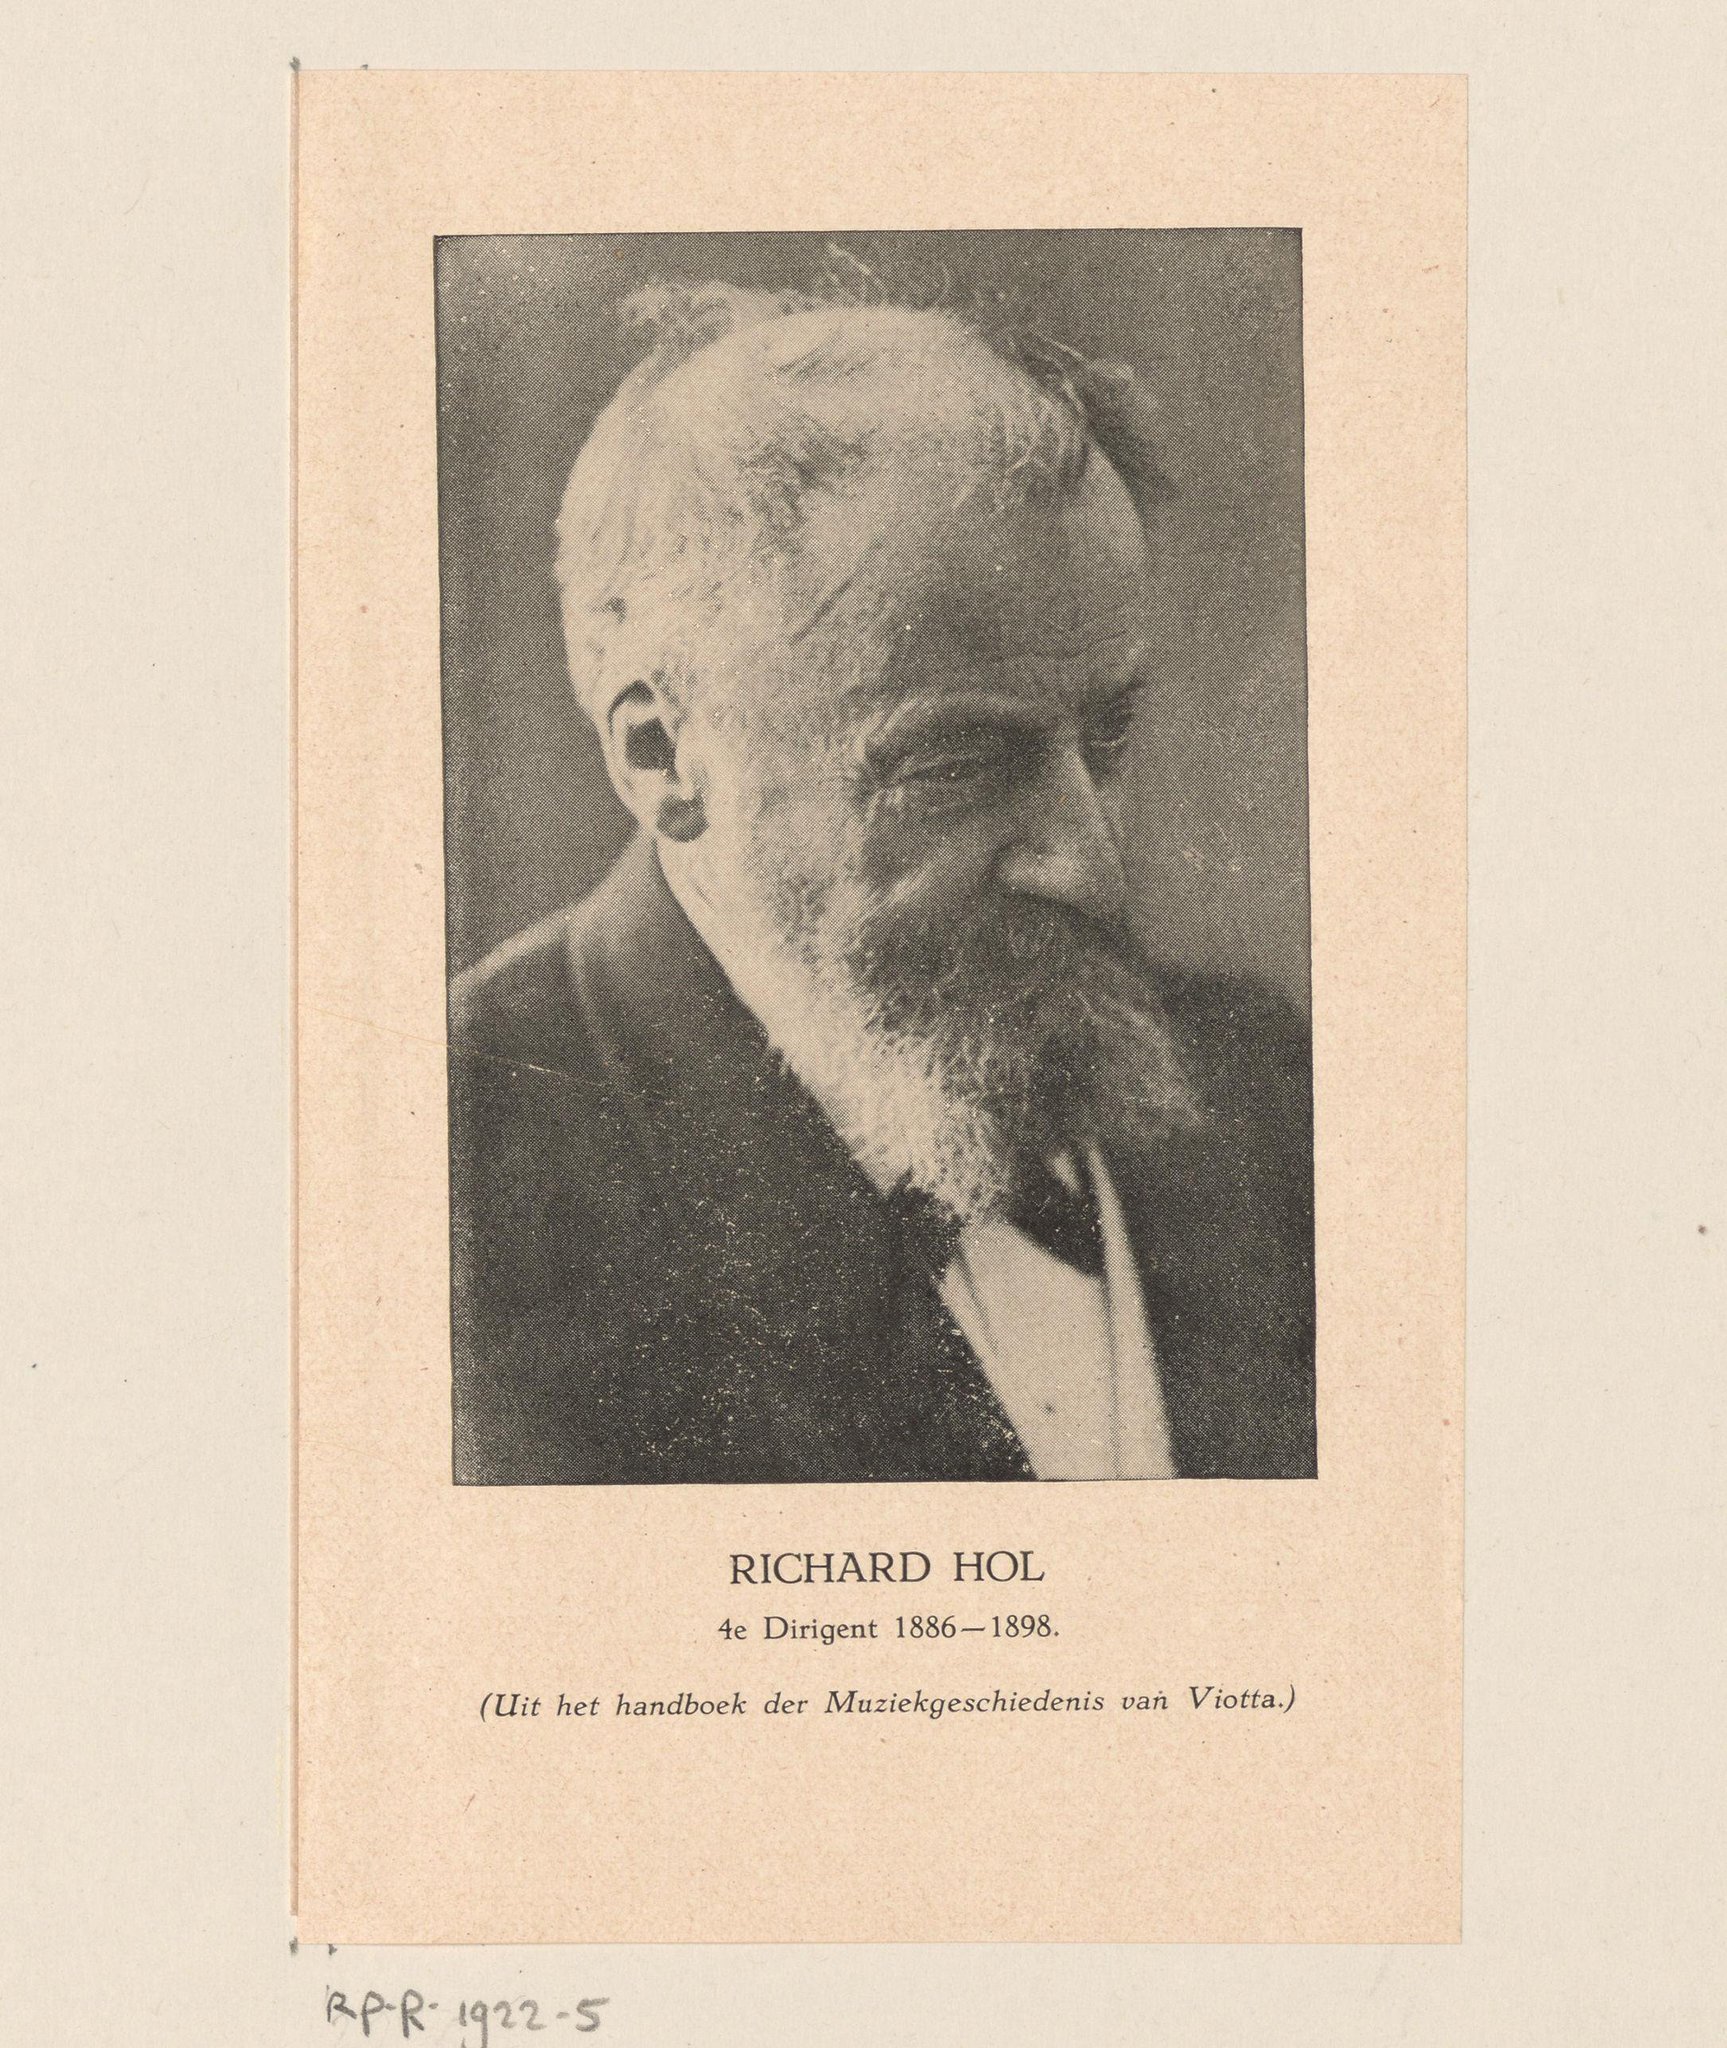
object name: reproduction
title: Portret van Richard Hol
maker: Anonymous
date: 1916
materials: paper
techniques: autotype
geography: haarlem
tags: amsterdam, historical persons, portrait of composer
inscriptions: collector's mark: Lugt 2233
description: Prent uit: Viotta, Henri. Handboek der muziekgeschiedenis. 2 dln. Haarlem: Tjeenk Willink, 1916.